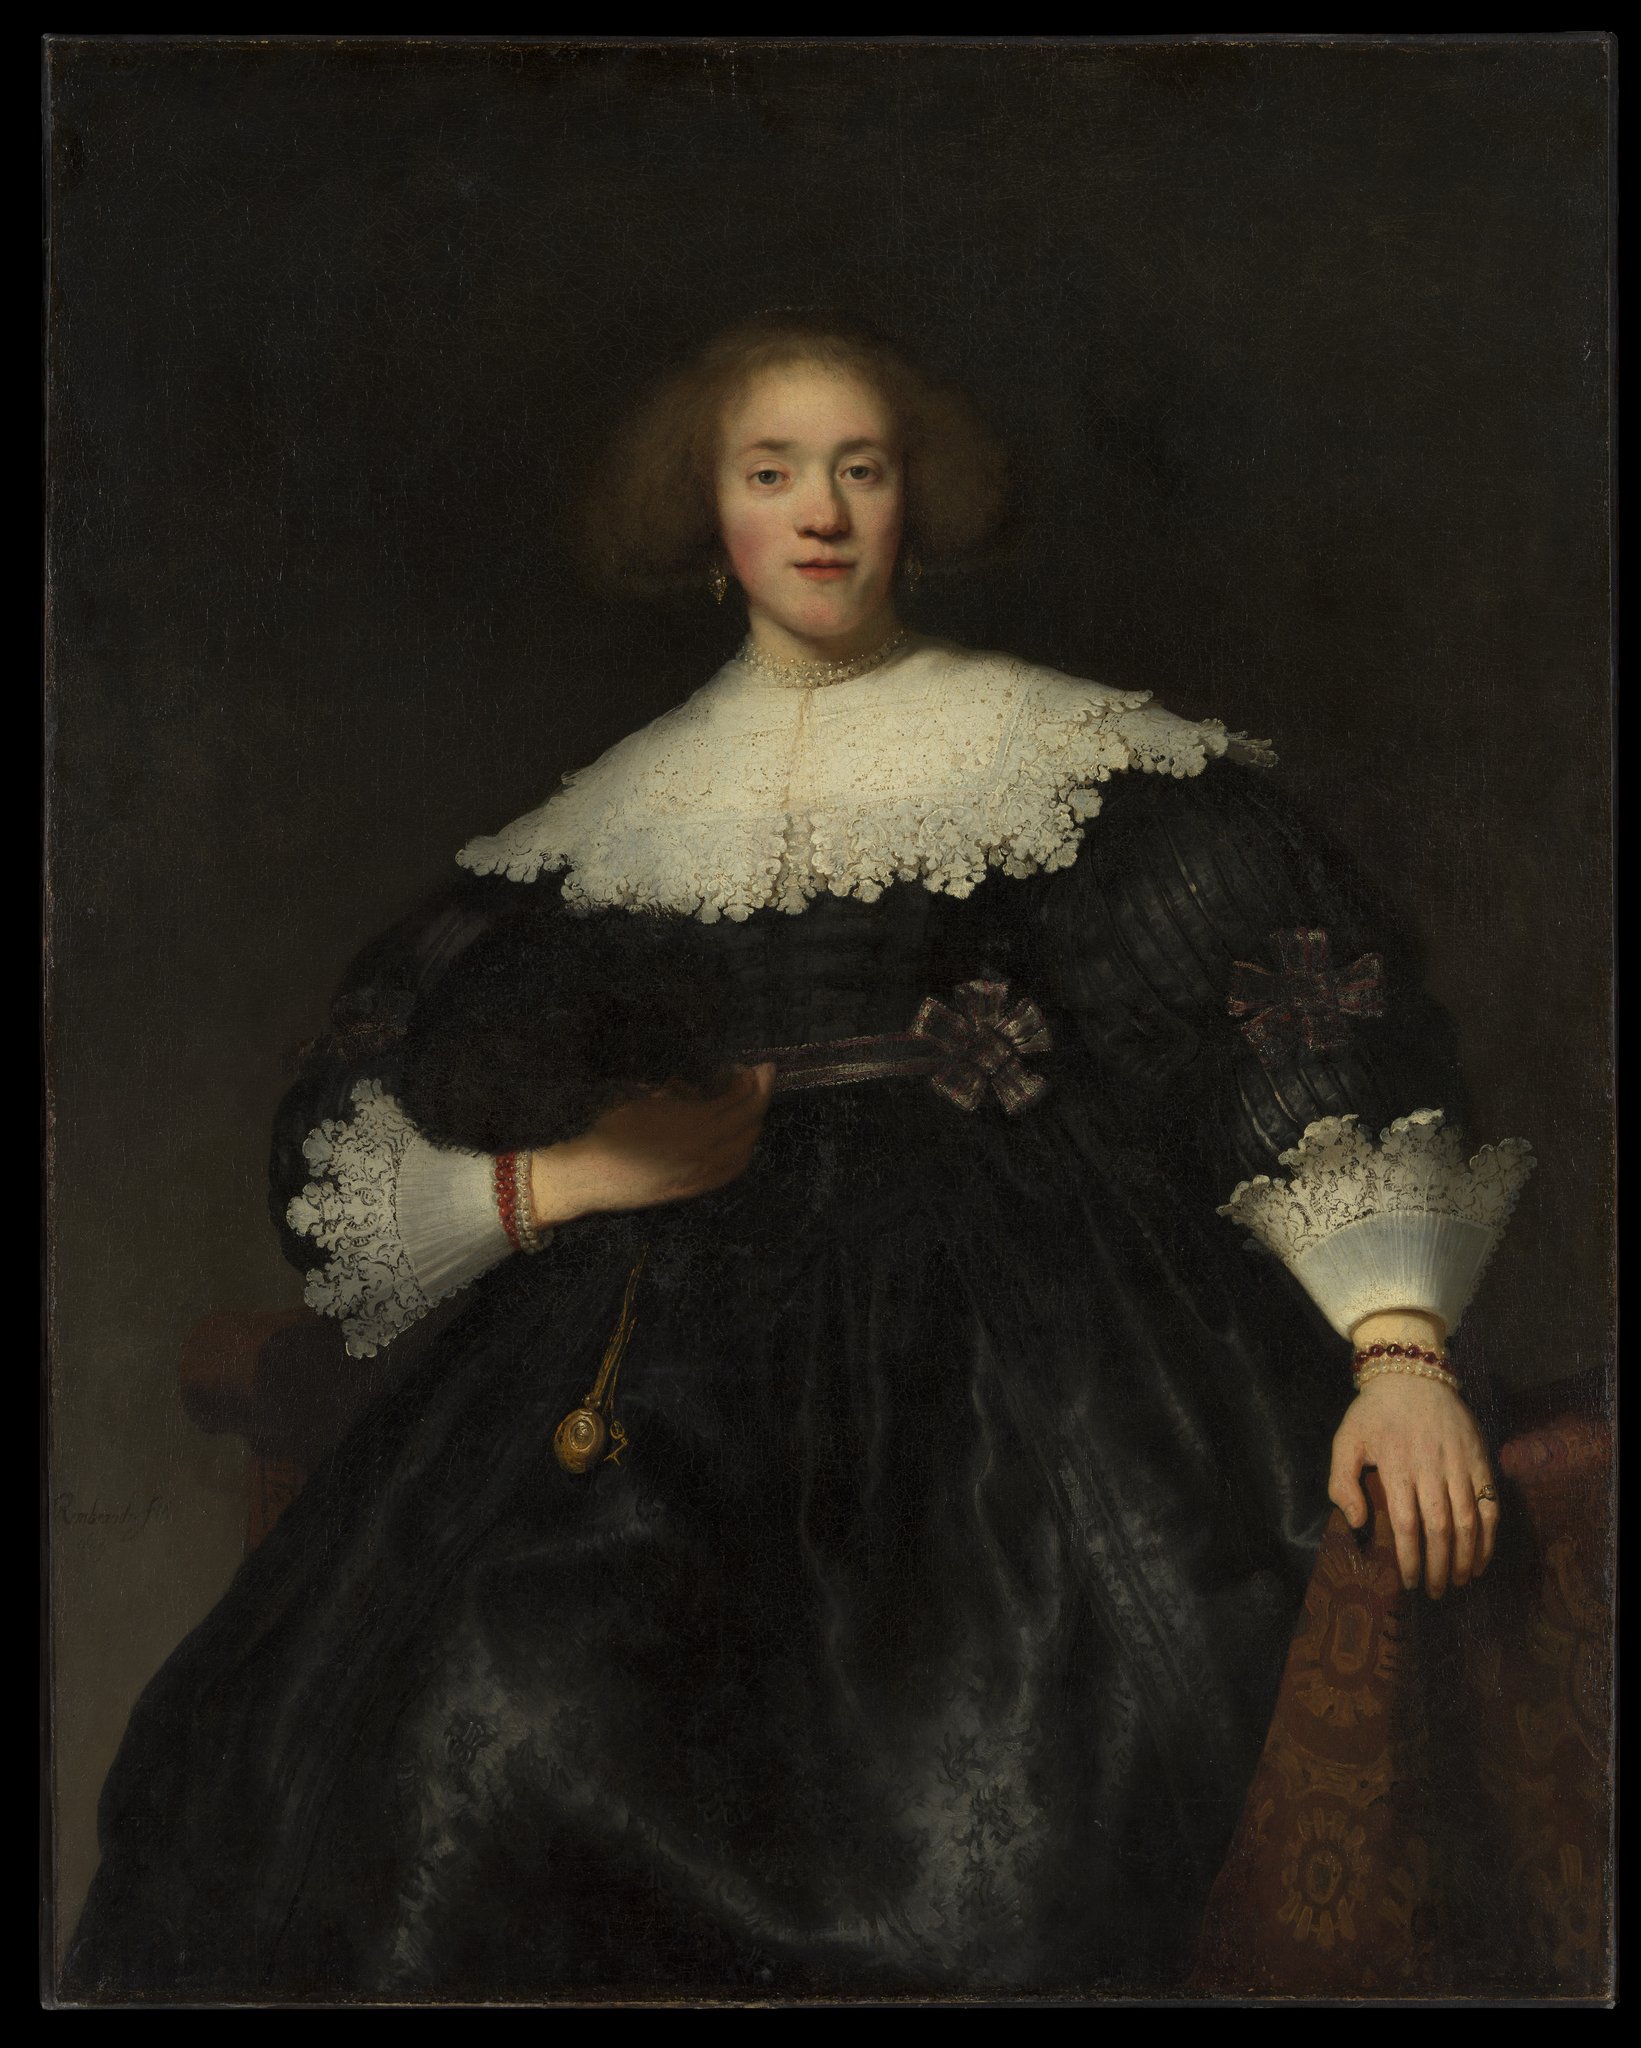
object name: painting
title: Portrait of a Young Woman with a Fan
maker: rembrandt van rijn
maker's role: artist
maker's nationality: dutch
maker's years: 1606-1669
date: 1633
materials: canvas, oil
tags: portraits,women